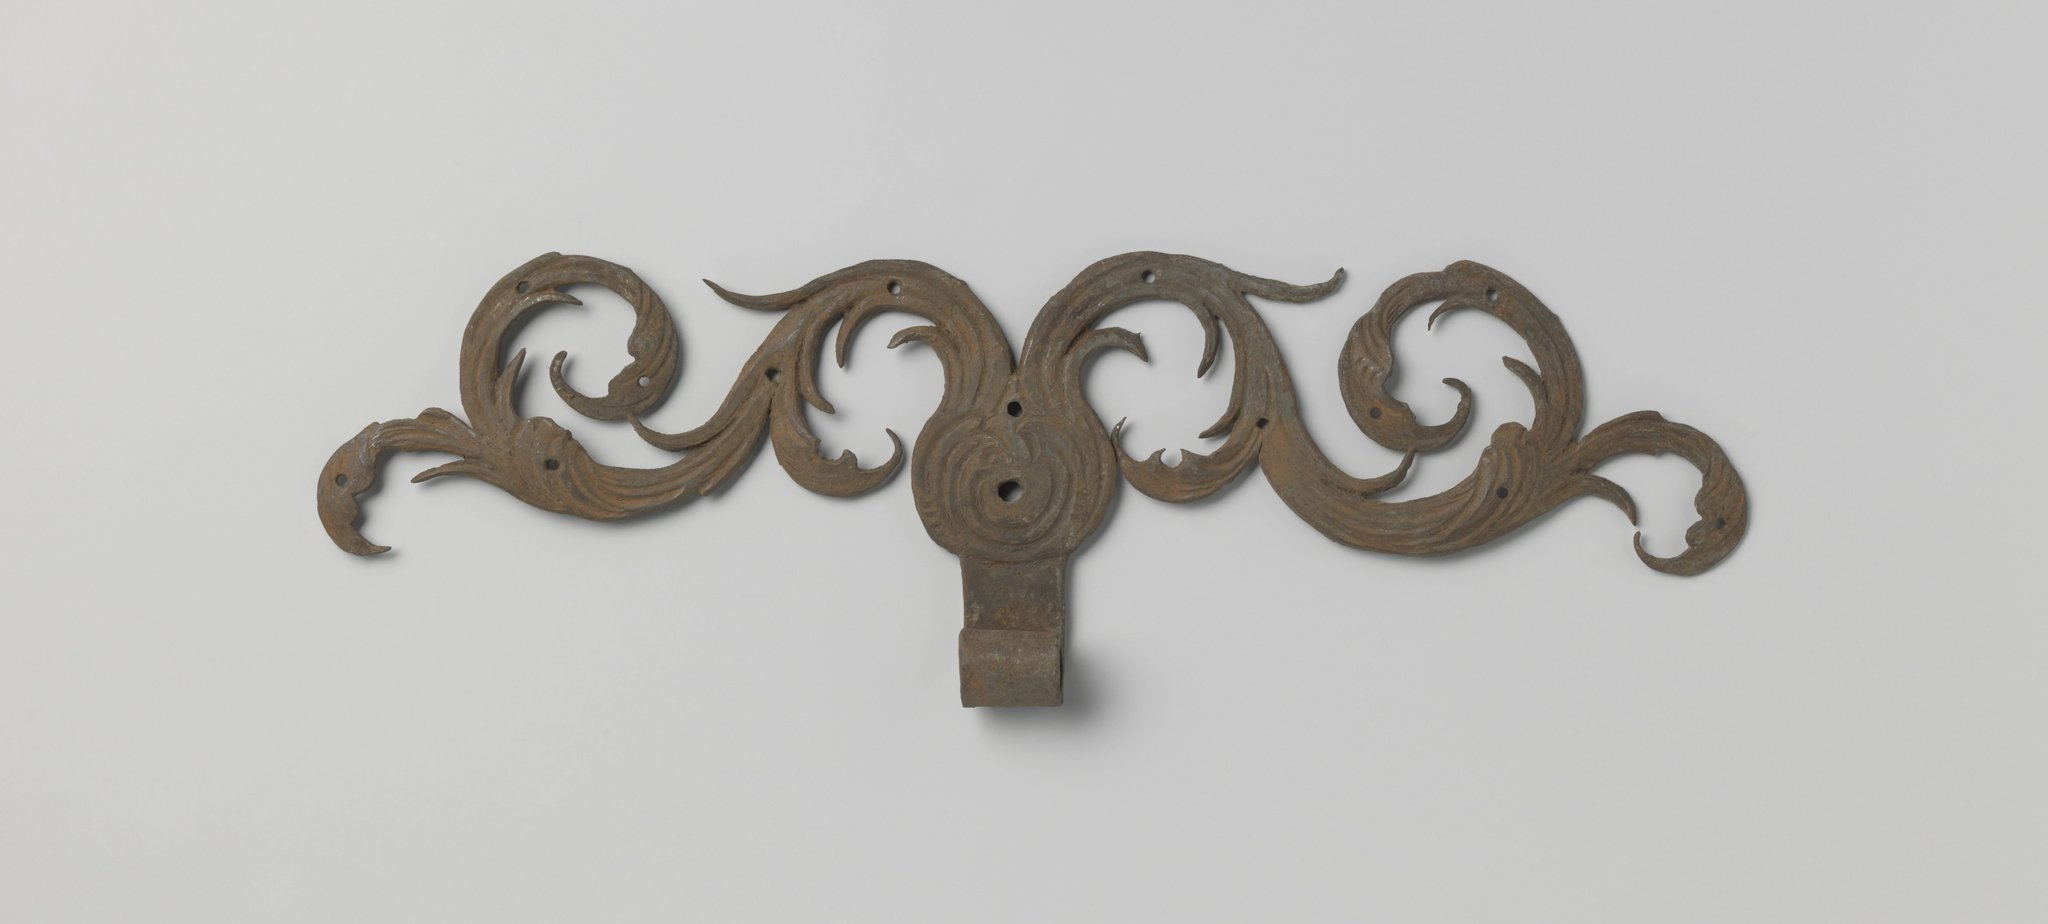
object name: hengsel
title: Hengsel van vertind ijzer met bladmotieven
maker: Anonymous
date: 1600-1800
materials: iron, tin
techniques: metalworking, tinning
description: Hengsel van vertind ijzer. Onderaan een grote, ronde opening van een scharnier met daaraan een ronde aanzet. Van daaruit ontspringen twee symmetrische bladmotieven, die naar het einde toe splitsen.